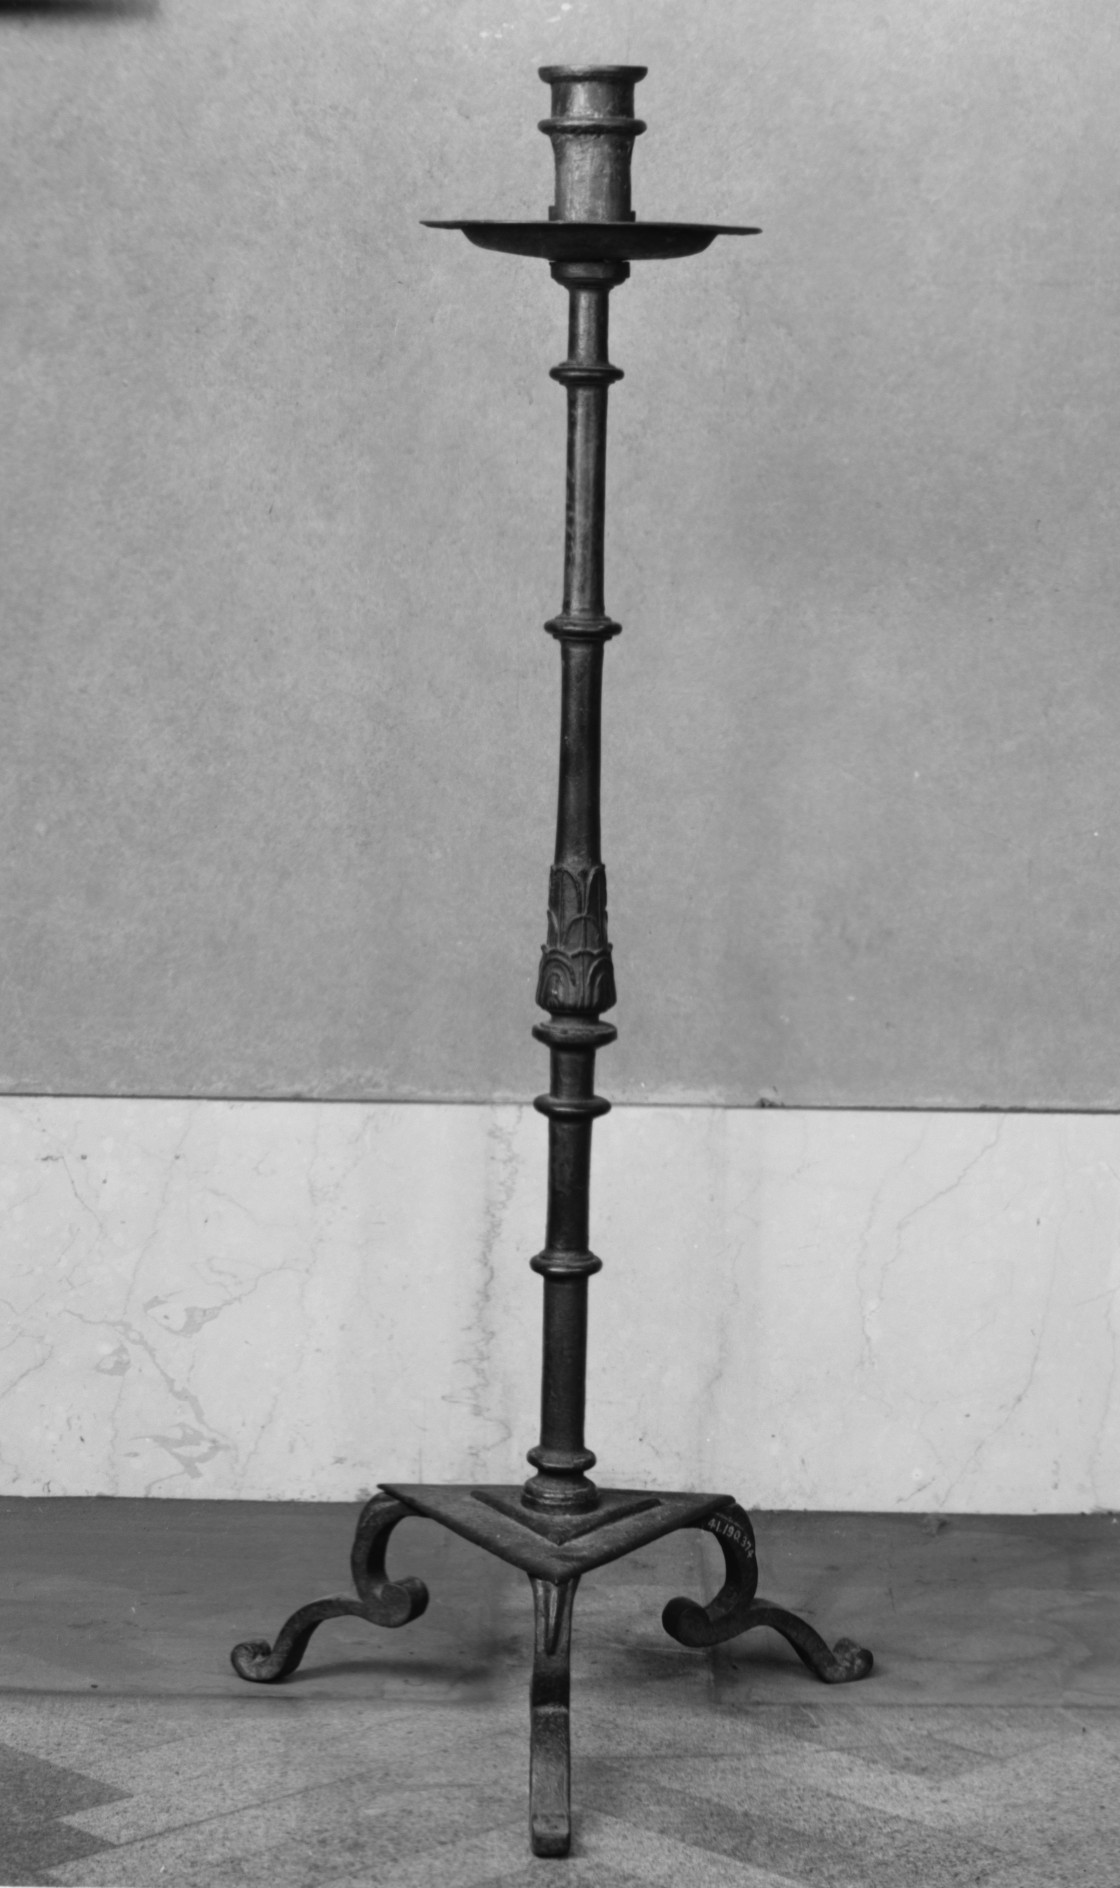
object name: candlestick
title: Standing candlestick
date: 1501-1600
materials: iron